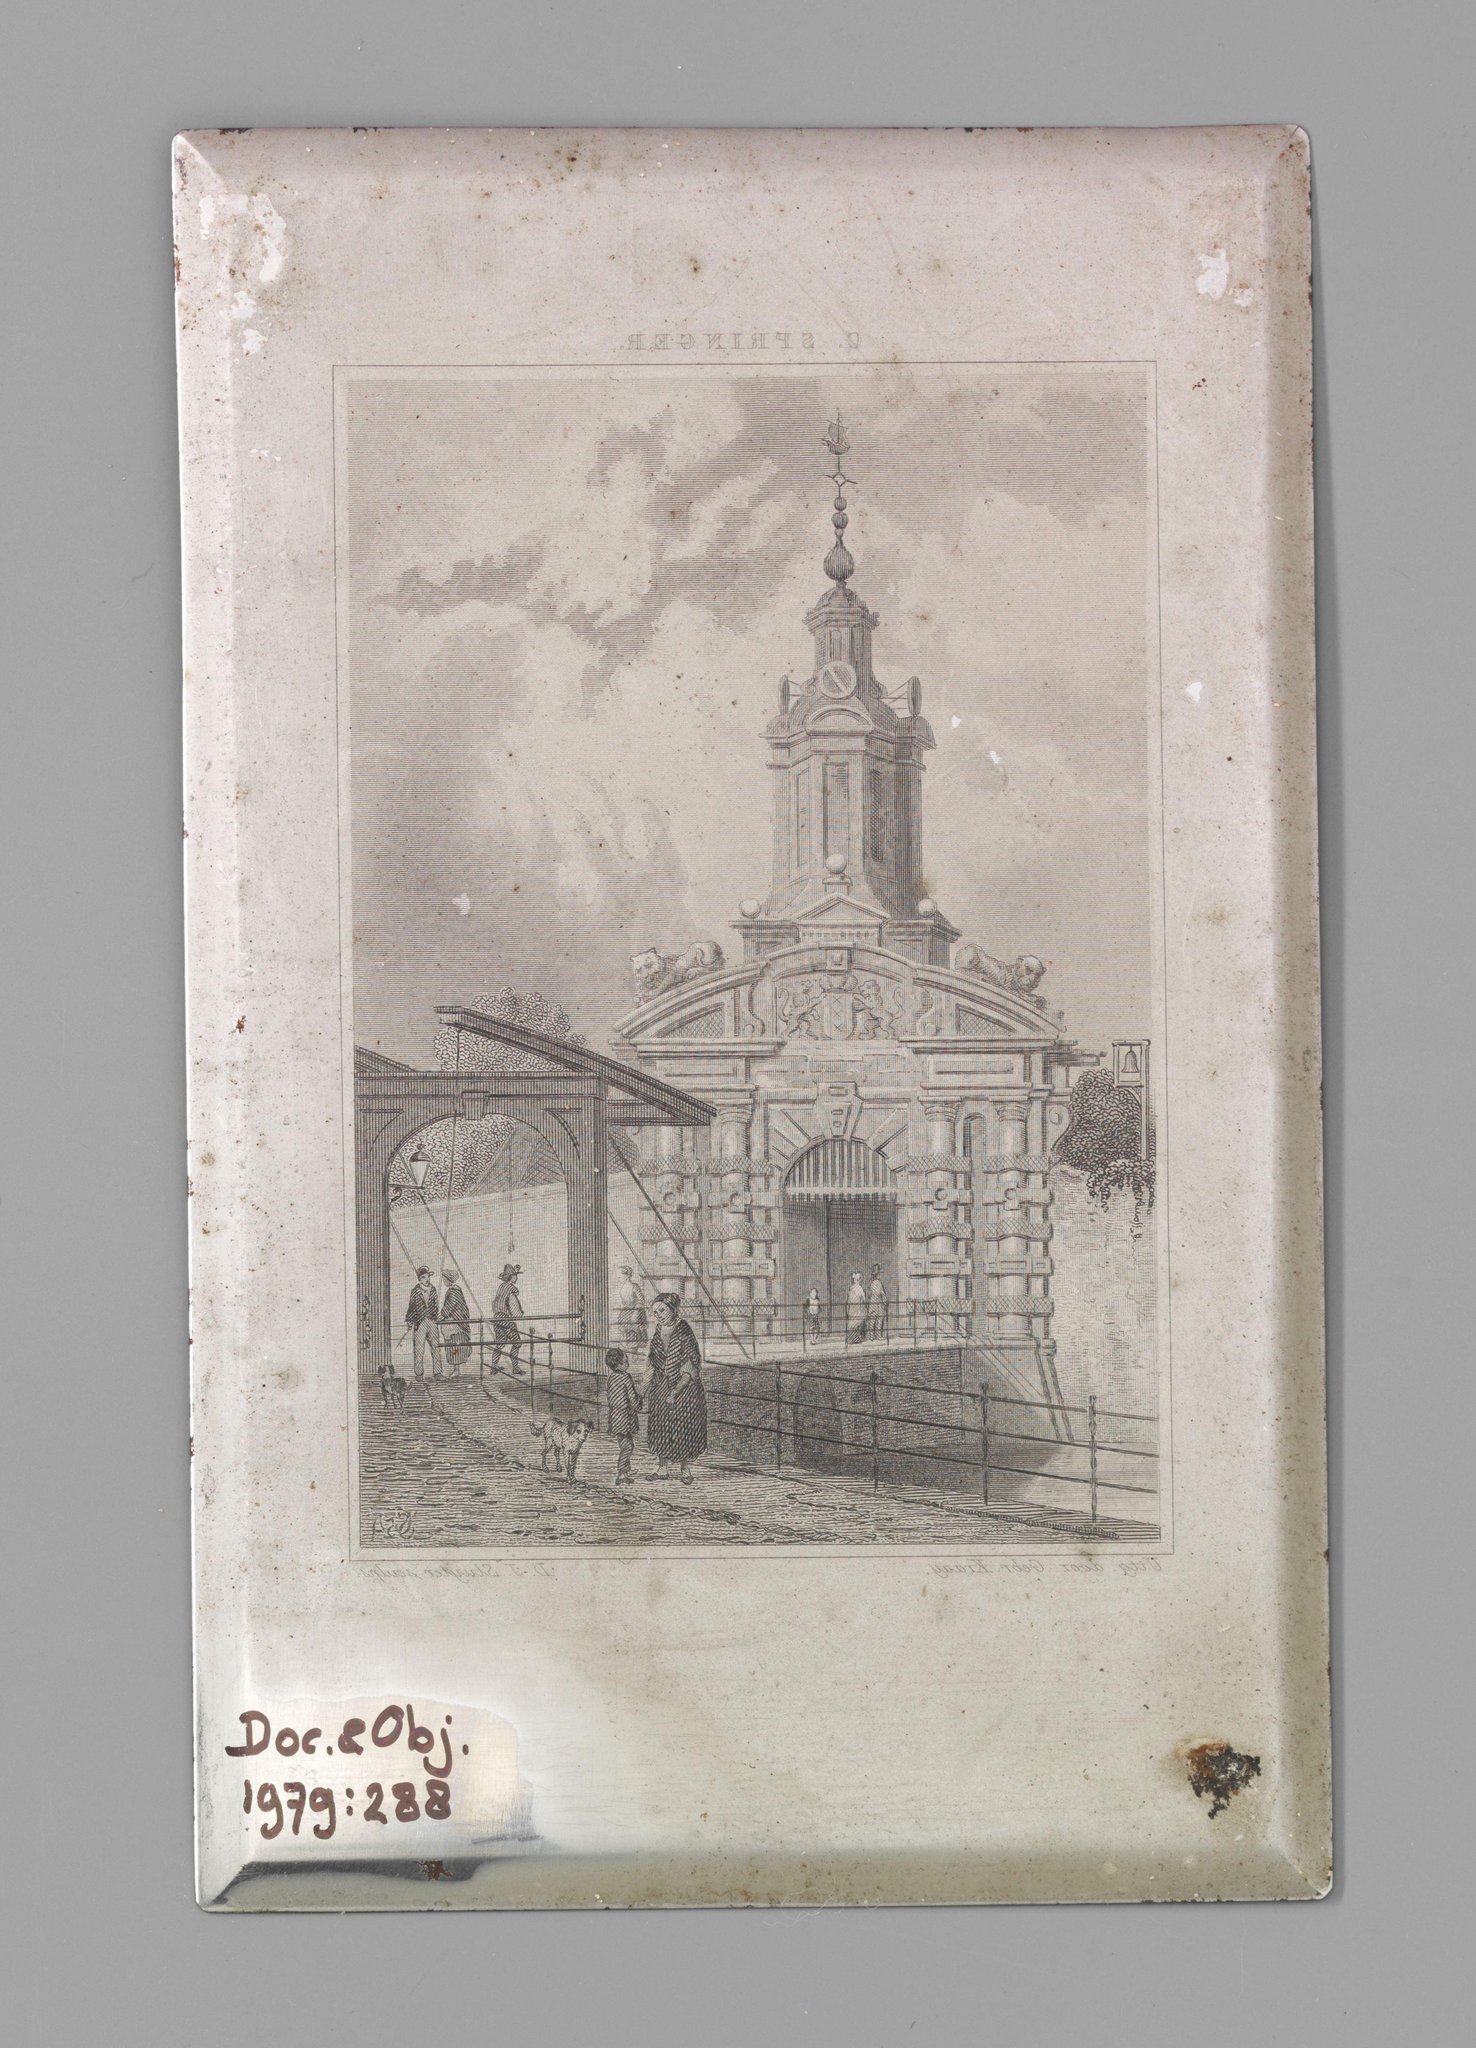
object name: staalplaat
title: Haarlemmerpoort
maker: dirk jurriaan sluyter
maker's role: draughtsman, print maker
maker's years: 1811-1886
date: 1850-1886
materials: steel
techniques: engraving